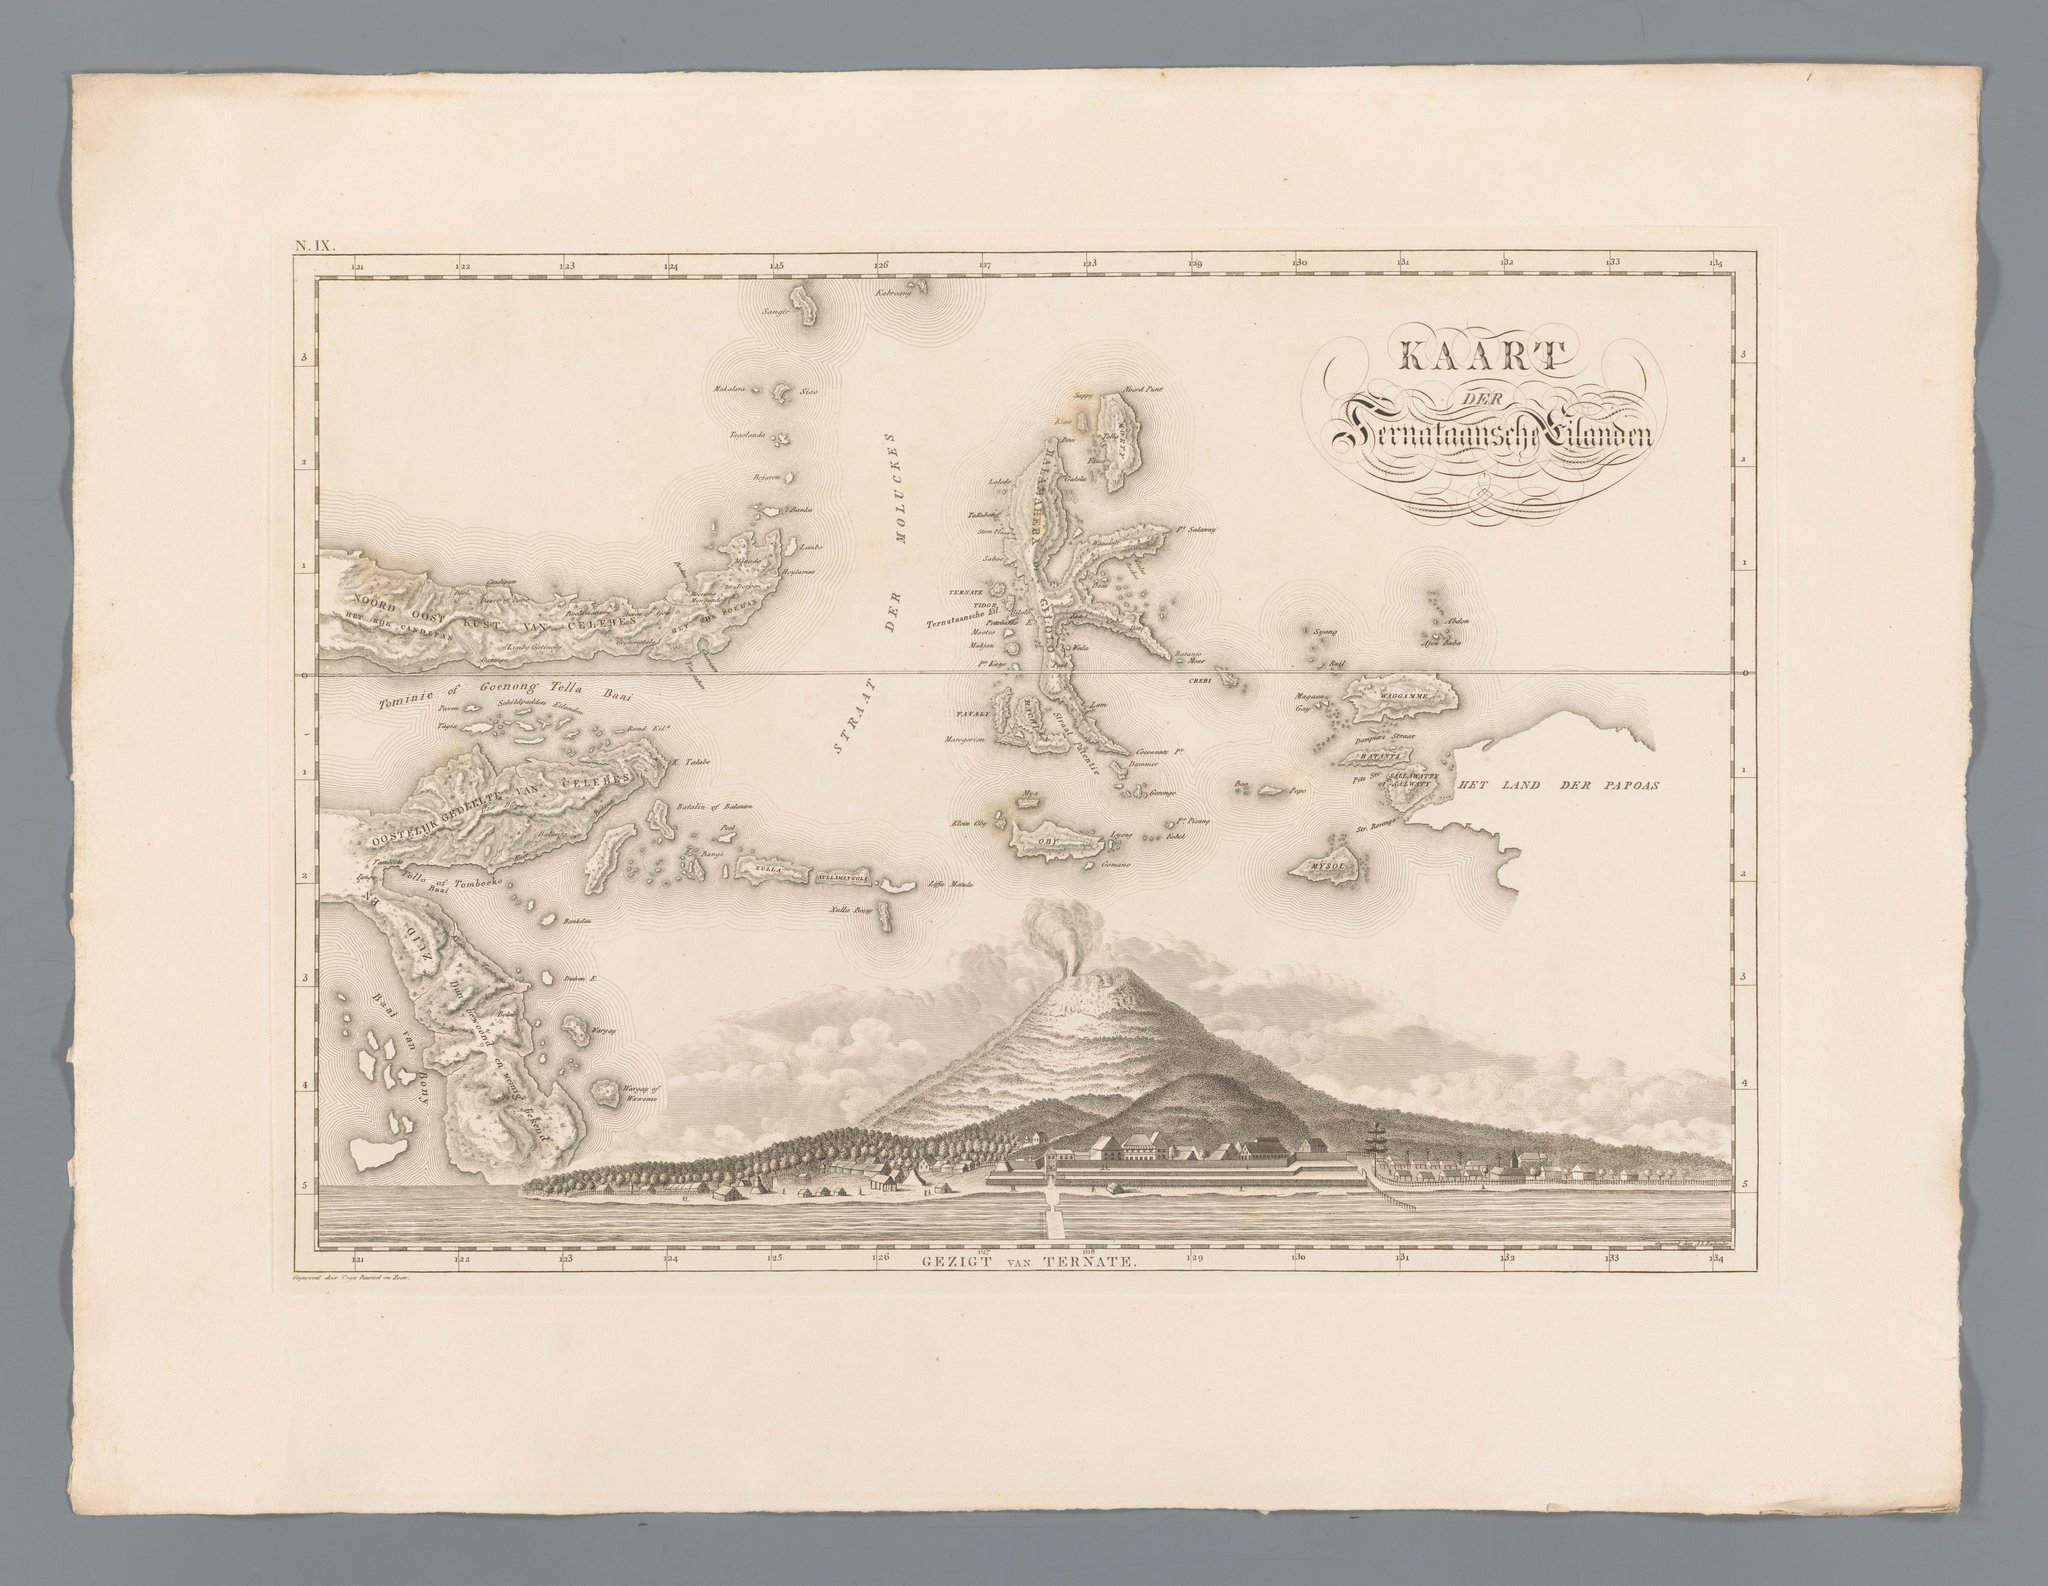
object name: map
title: Gezigt van Ternate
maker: abraham lion zeelander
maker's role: draughtsman, print maker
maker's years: 1789-1856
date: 1818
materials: paper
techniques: engraving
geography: the hague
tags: maps of separate countries or regions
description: Kaart uit: Bosch, Js. van den. Atlas der overzeesche bezittingen van Zijne Majesteit den Koning der Nederlanden, aan hoogst denzelven opgedragen. Den Haag en Amsterdam: Gebroeders van Cleef, 1818.